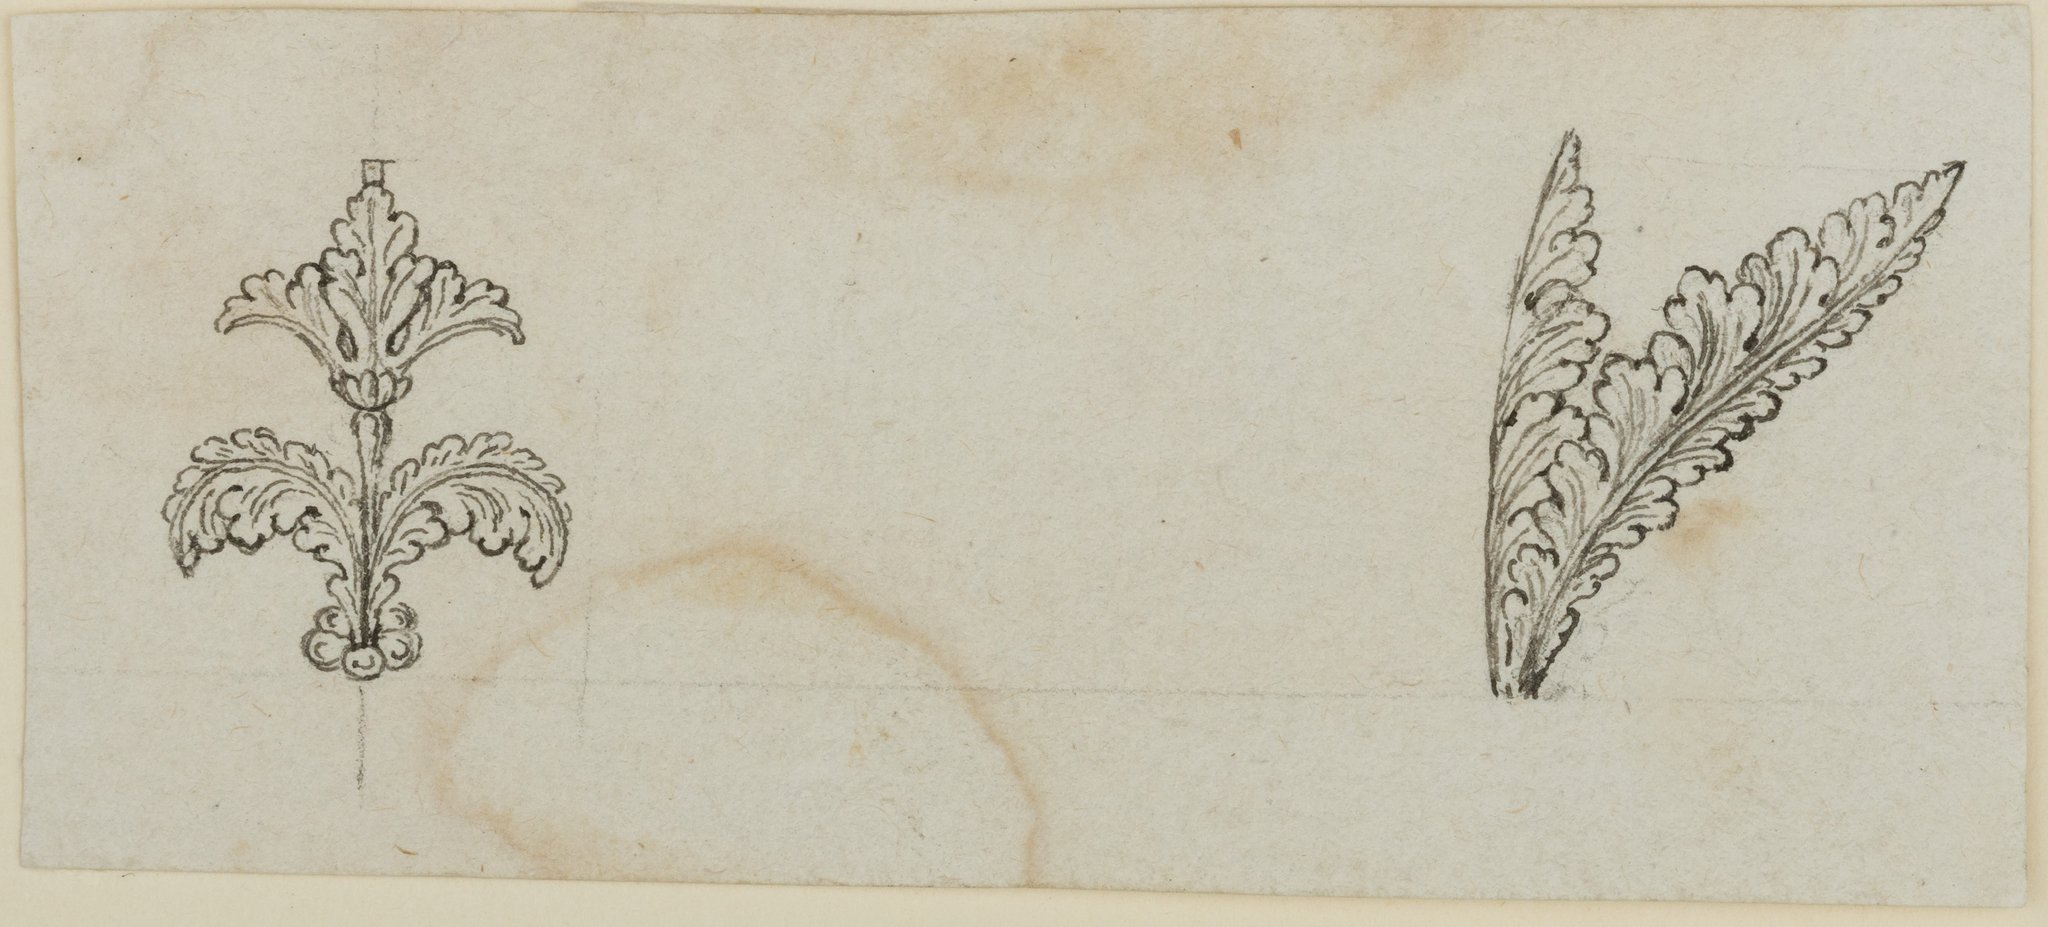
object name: drawing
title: Two Designs for the Decoration of Firearms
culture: french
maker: nicolas noël boutet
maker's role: designer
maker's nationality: french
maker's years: 1761-1833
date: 1797-1805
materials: ink, paper, pencil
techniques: wash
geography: france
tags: ornament,leaves